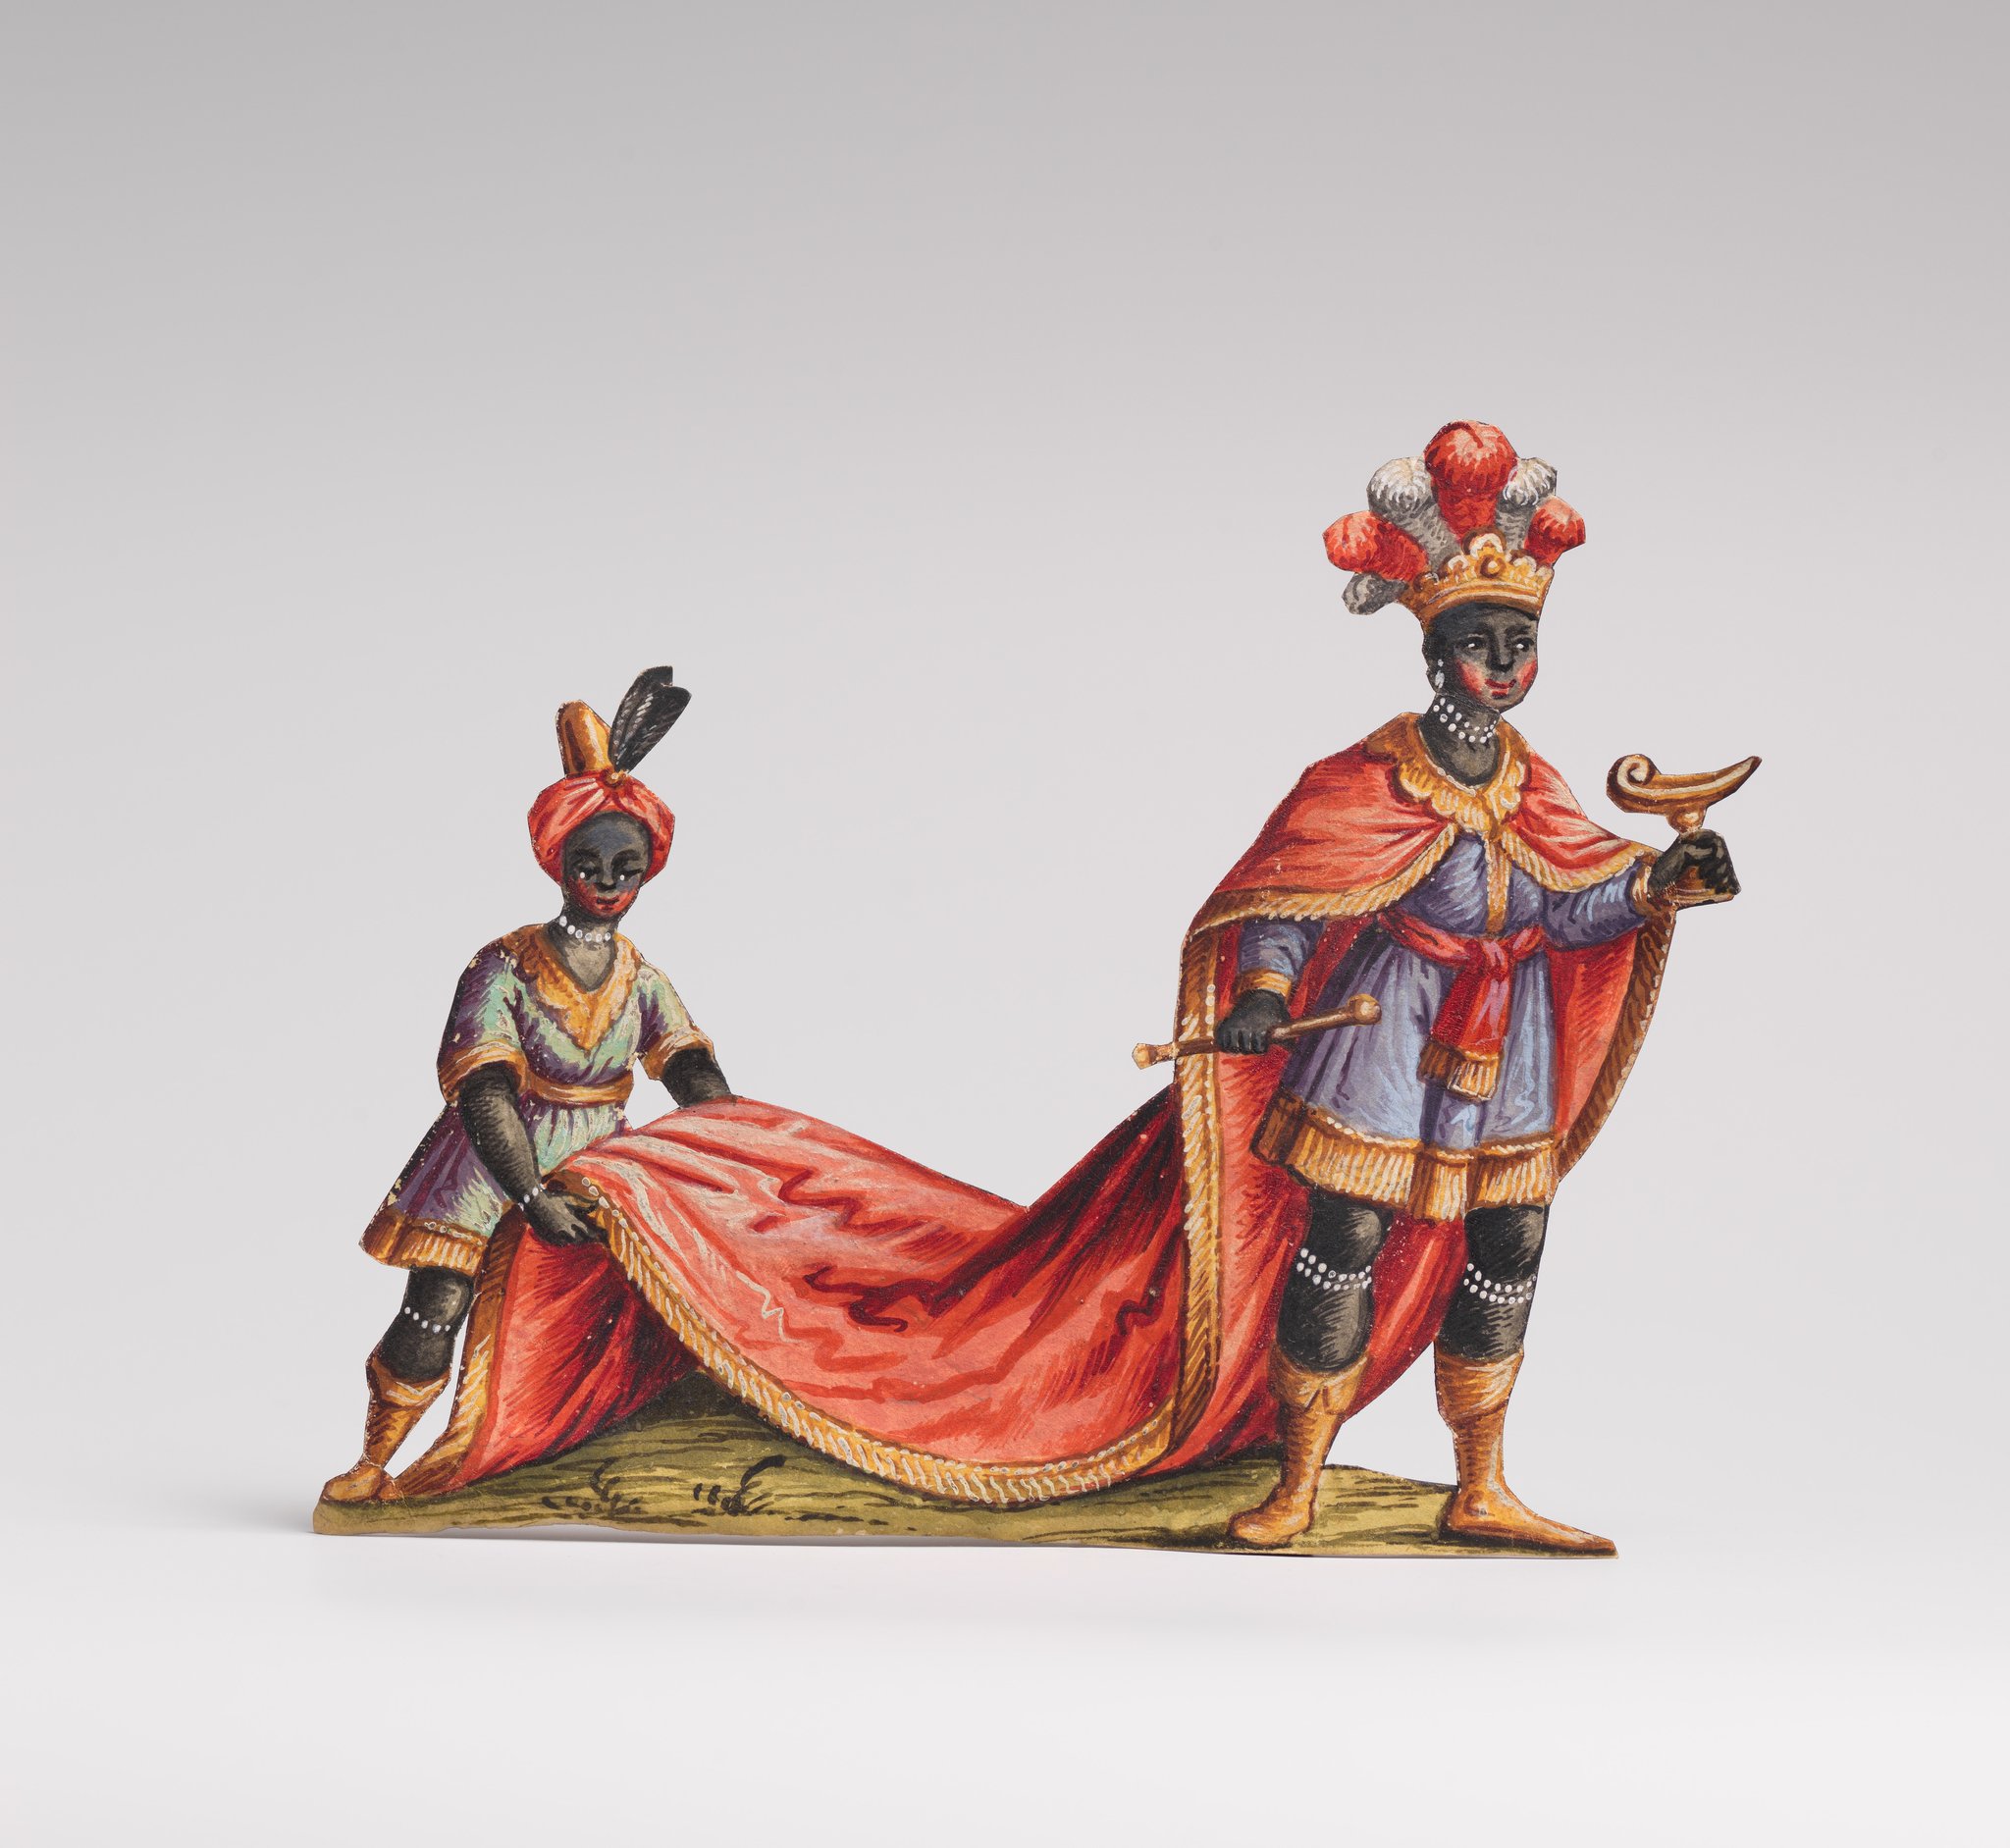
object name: figure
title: Magus with Attendant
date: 1701-1800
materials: gouache, paper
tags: men